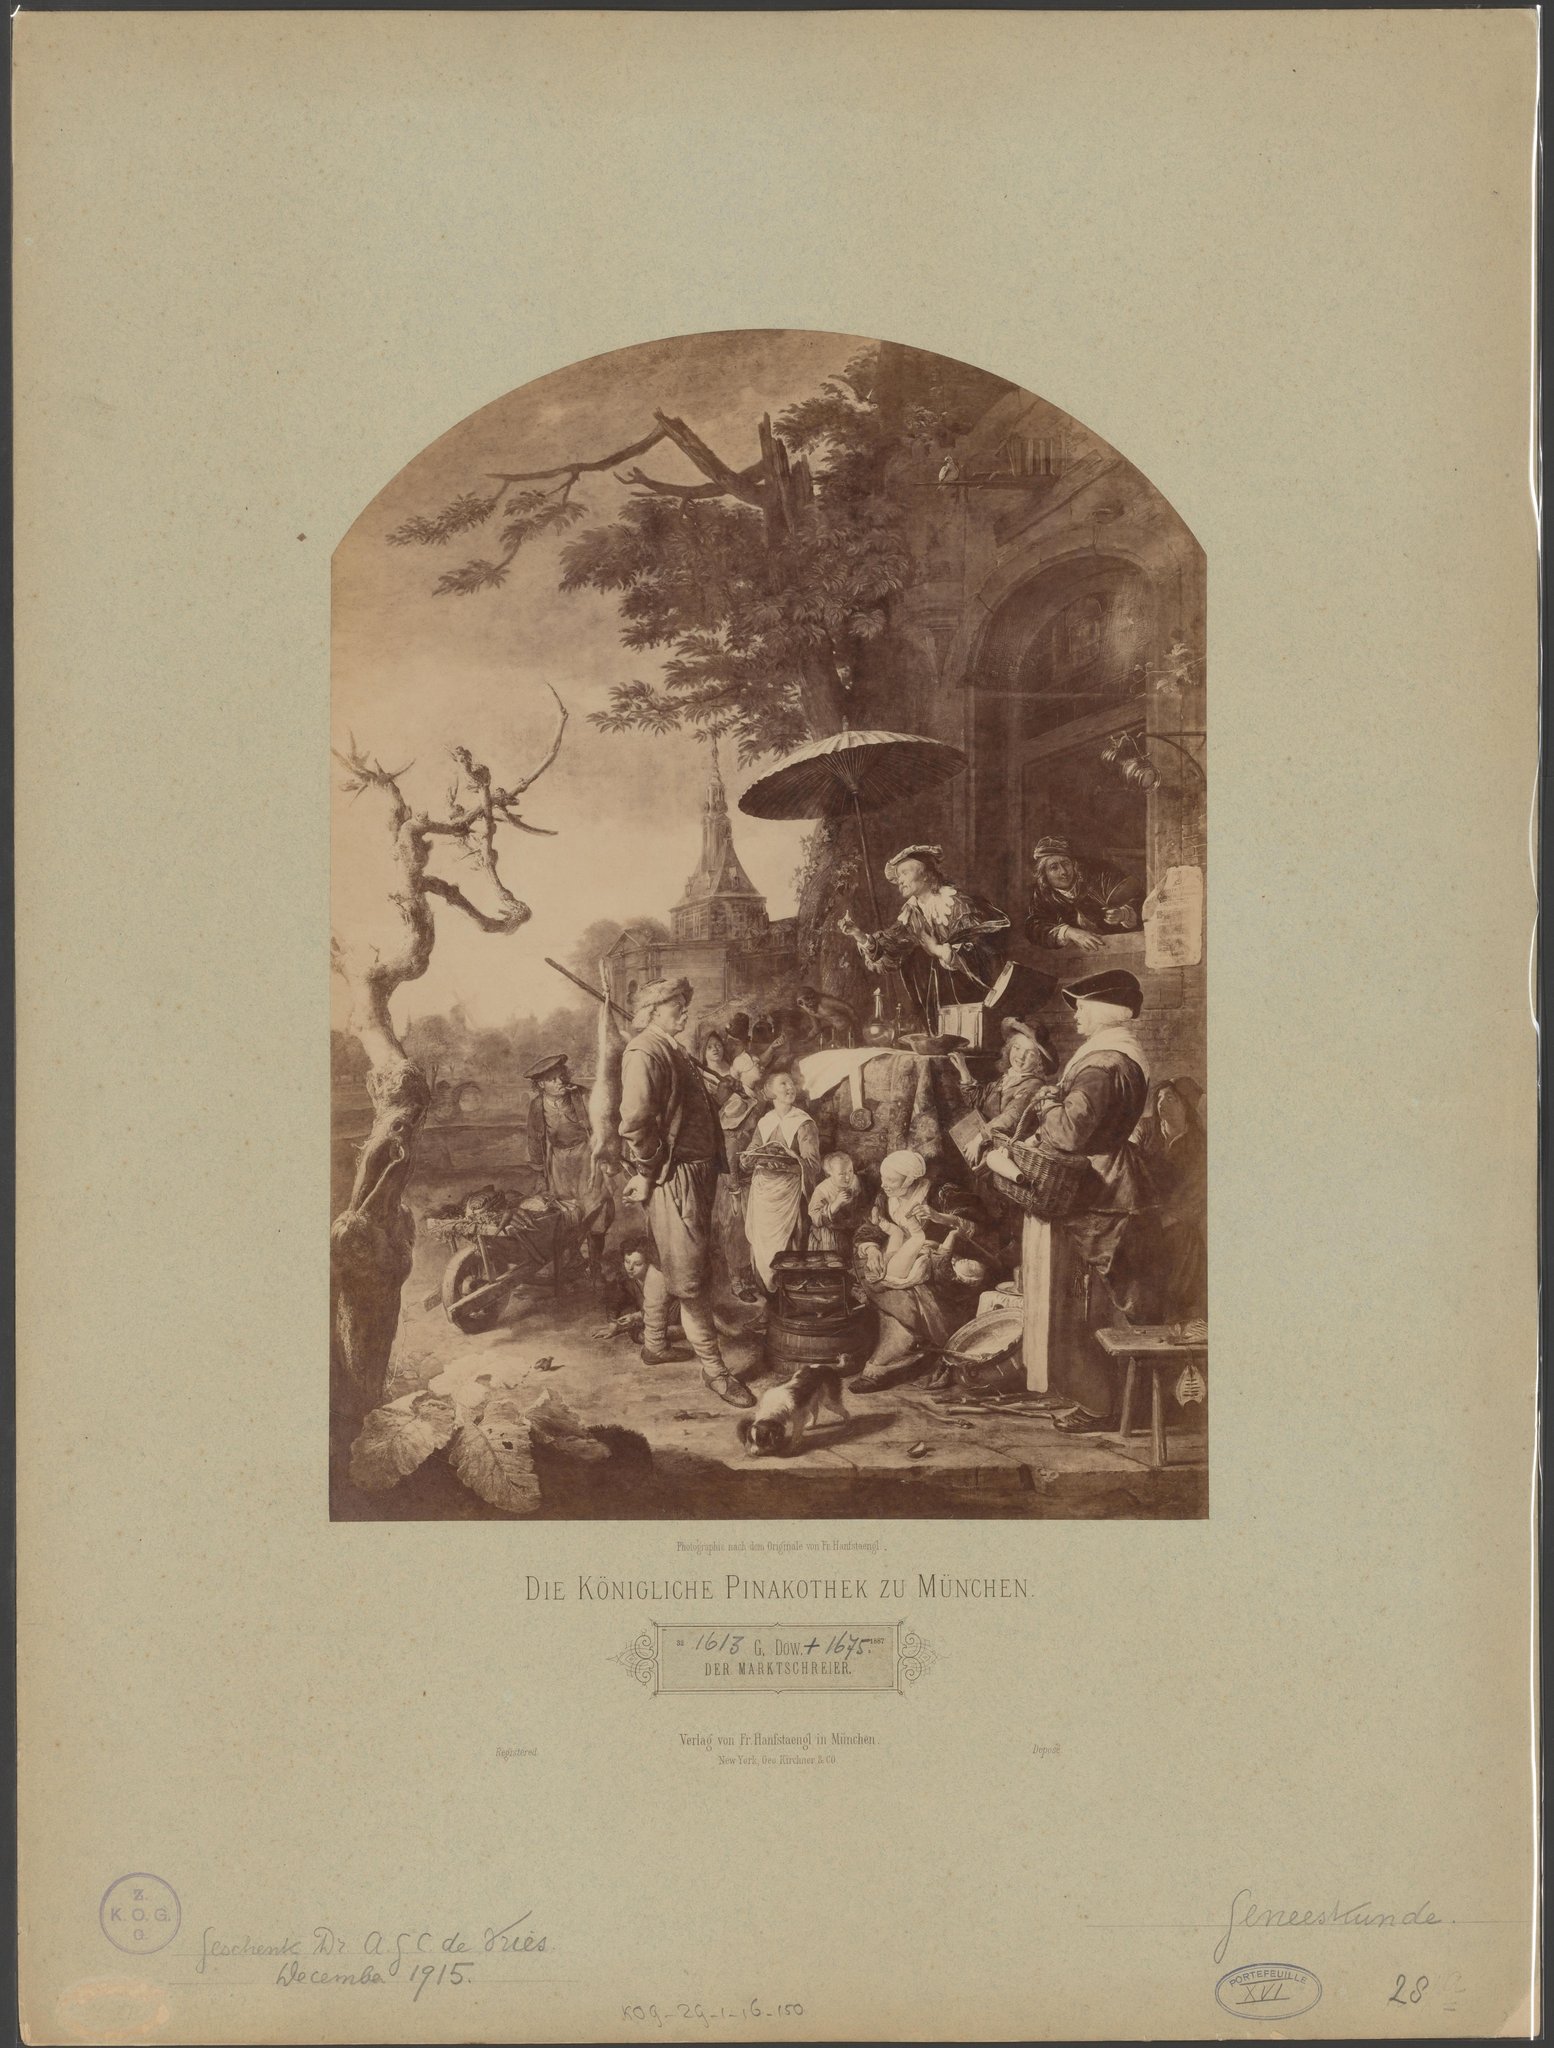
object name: photograph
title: Fotoreproductie van schilderij De kwakzalver door Gerard Dou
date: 1887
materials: cardboard, paper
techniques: carbon print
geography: munich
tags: quack, charlatan, mountebank, 'saltimbanco'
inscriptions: collector's mark, collector's mark: Lugt 1641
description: Een kwakzalver onder een parasol op een podium prijst zijn waar aan. Onderwerpsrubrieken binnen de Atlas Zeden en Gewoonten: Onderwijs en Wetenschappen: Geneeskunde.